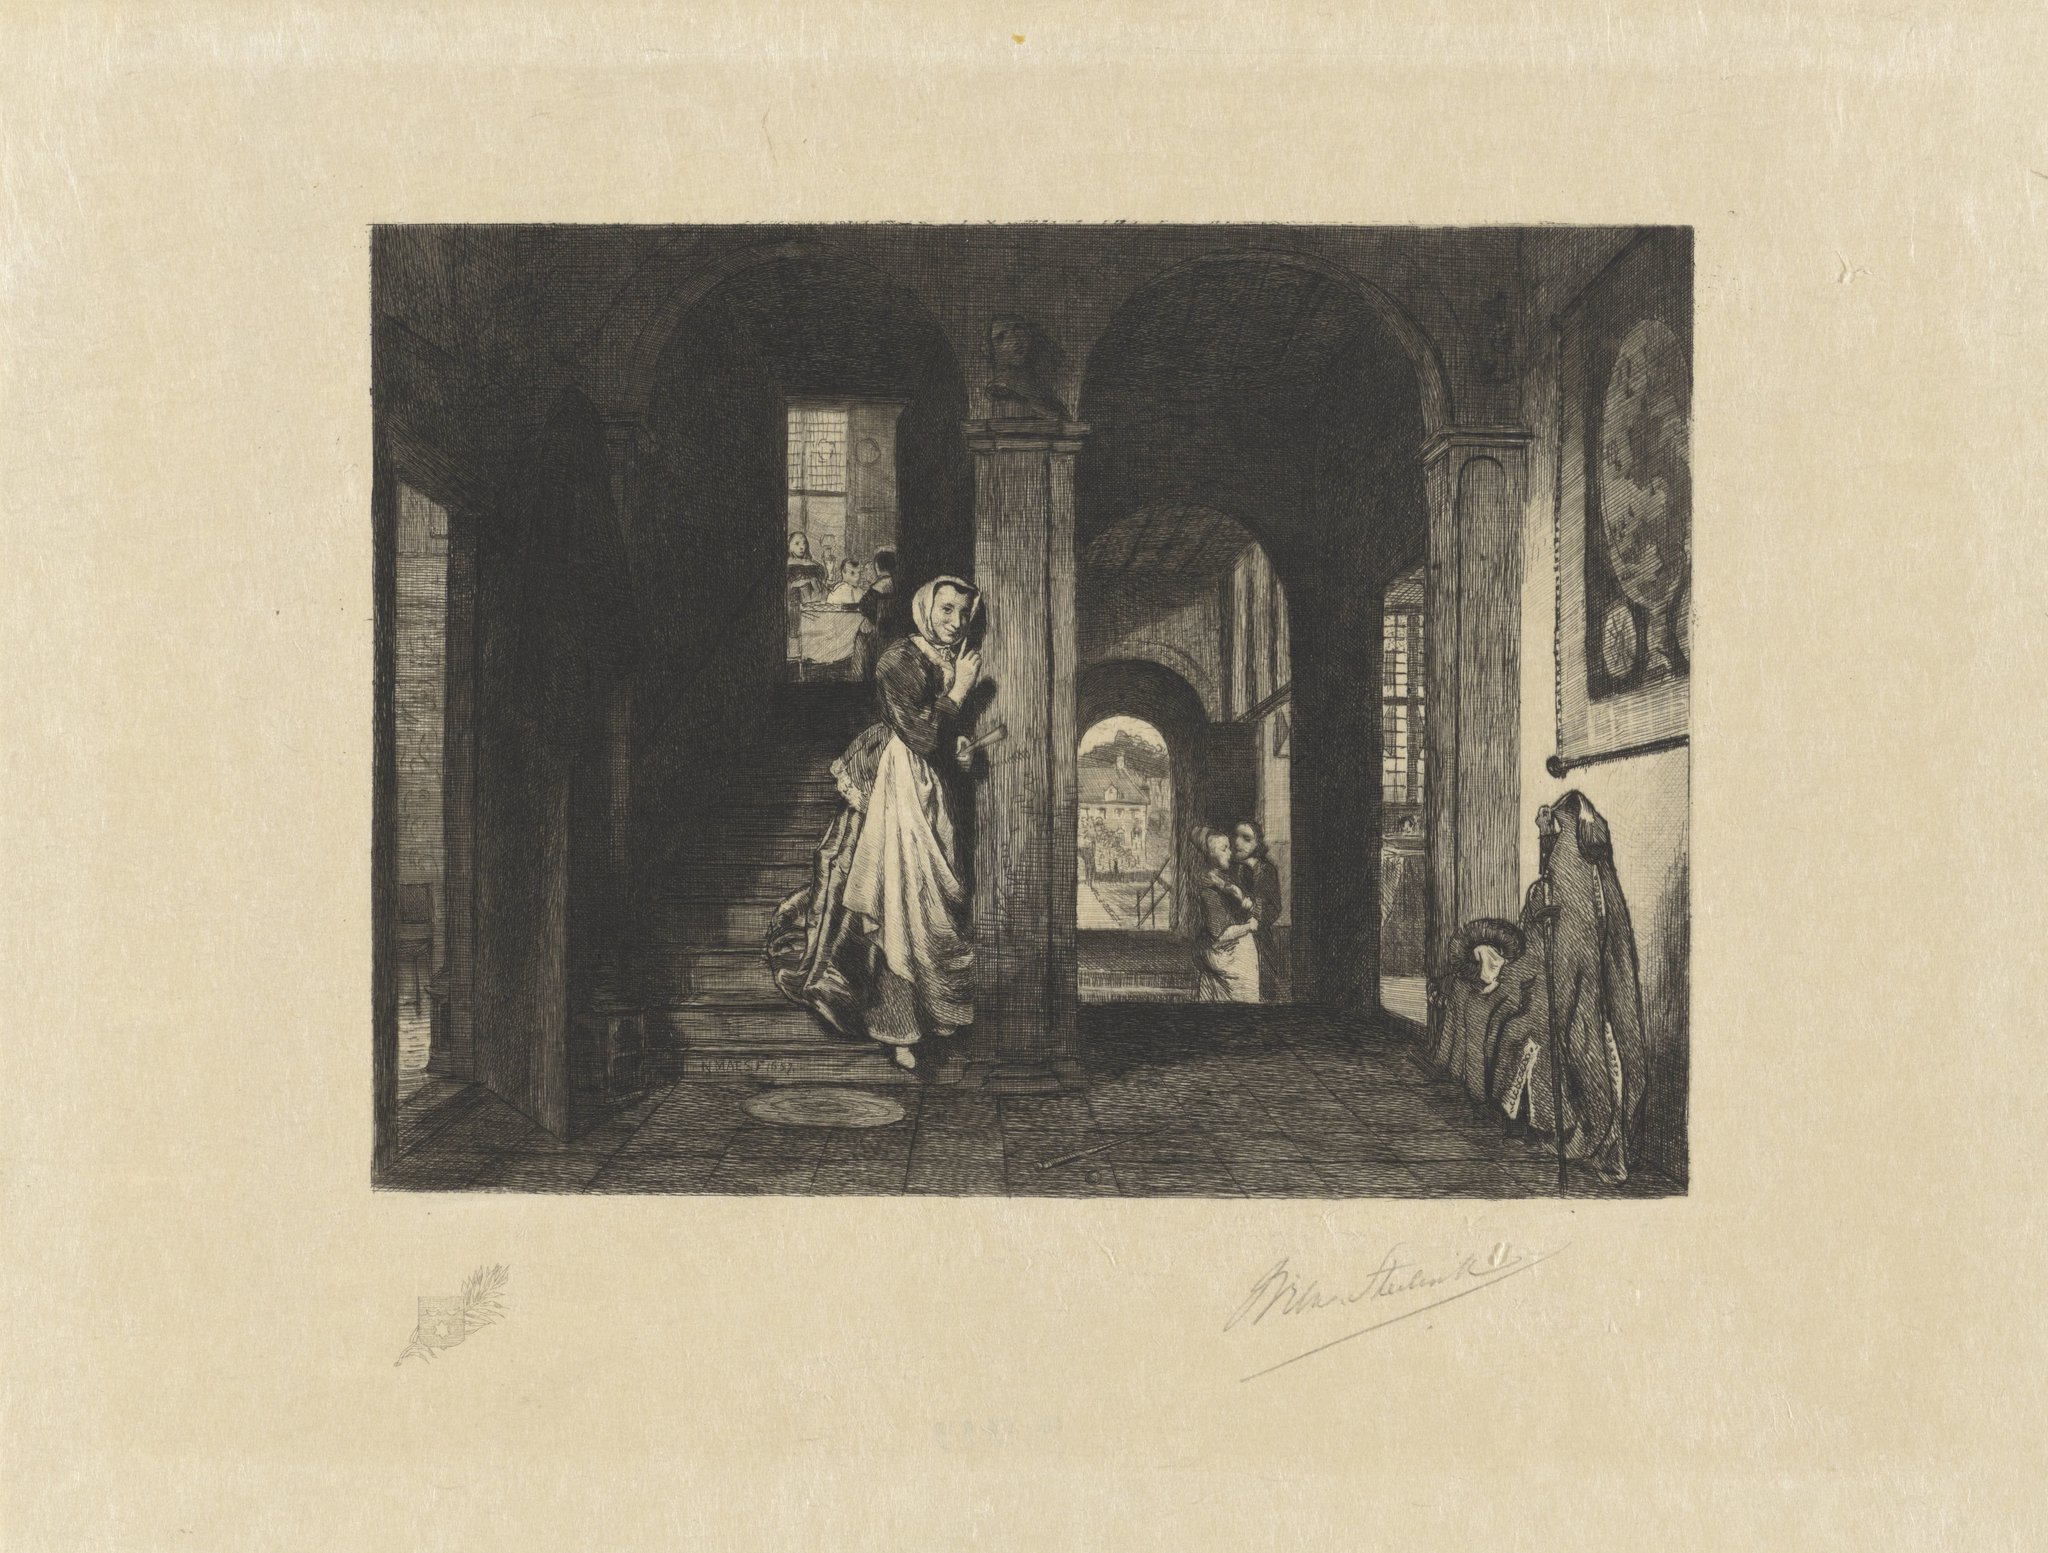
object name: print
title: De luistervink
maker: willem steelink (ii)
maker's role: draughtsman, print maker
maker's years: 1856-1928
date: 1888-1891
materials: paper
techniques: etching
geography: netherlands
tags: putting a finger to the lips, 'silentium'; 'silentio' (ripa), (lovers) caressing each other, eavesdropper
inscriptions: collector's mark: Lugt 2228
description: Prent mogelijk gebruikt in: Oude kunst in Nederland : etsen van Wilm. Steelink, naar schilderijen uit de kabinetten van A. Bredius, A.J. Enschedé, J.P. Six, P.H. Siz, H.A. Steengracht van Duivenvoorde, Victor de Stuers en andere verzamelingen. Amsterdam: Van Holkema & Warendorf, 1888-1891.